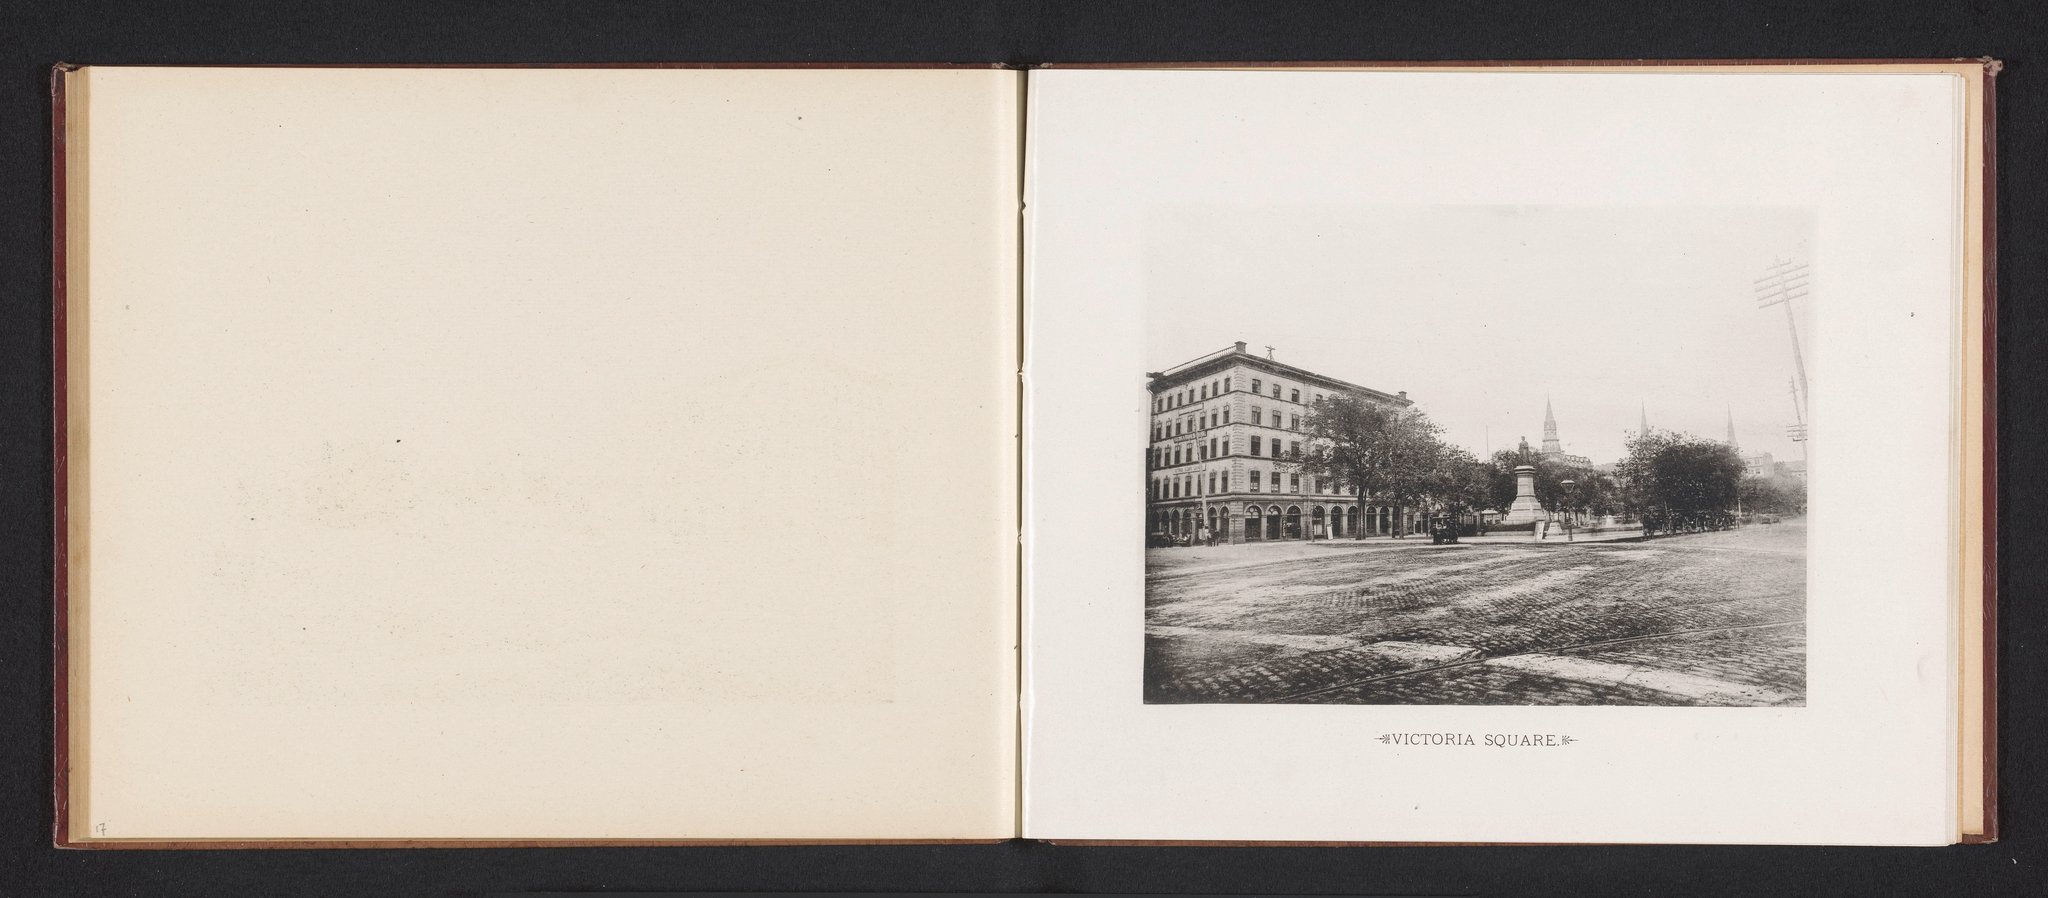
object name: photomechanical print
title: Victoria Square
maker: Anonymous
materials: paper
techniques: photograph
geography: montreal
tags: square, place, circus, etc., monument, statue